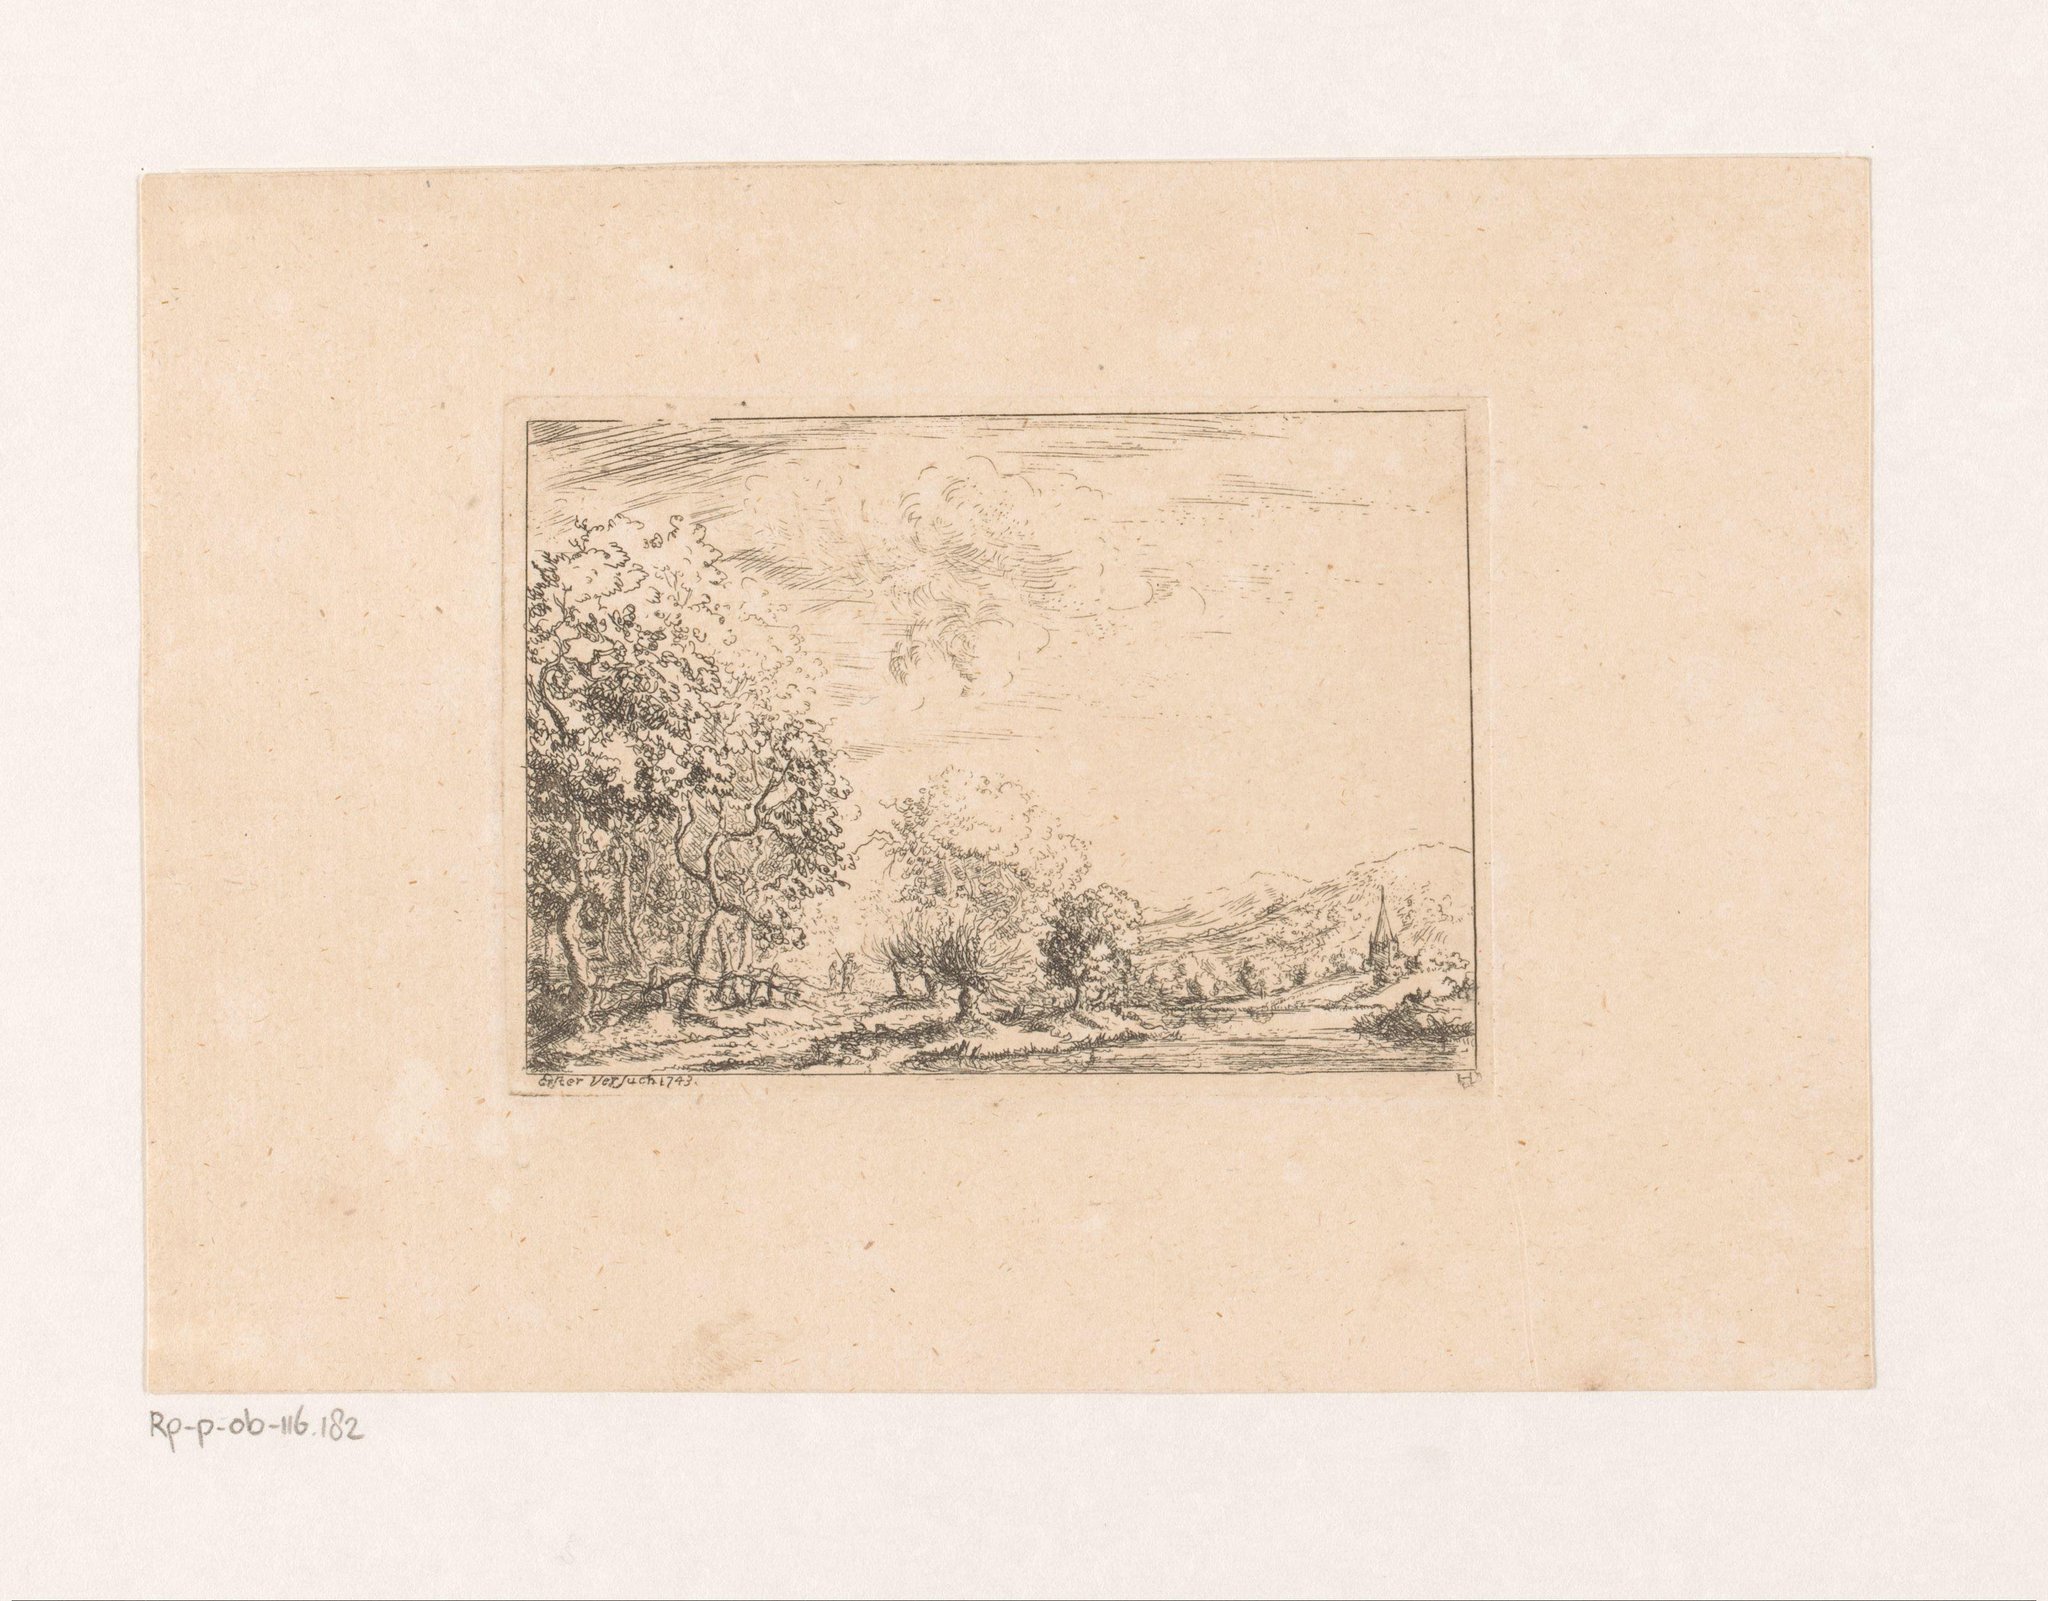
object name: print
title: Landschap met torenspits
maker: christian ludwig von hagedorn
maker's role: painter, print maker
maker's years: 1712-1780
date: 1743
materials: paper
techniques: etching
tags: low hill country (+ landscape with figures, staffage)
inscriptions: collector's mark: Lugt 240